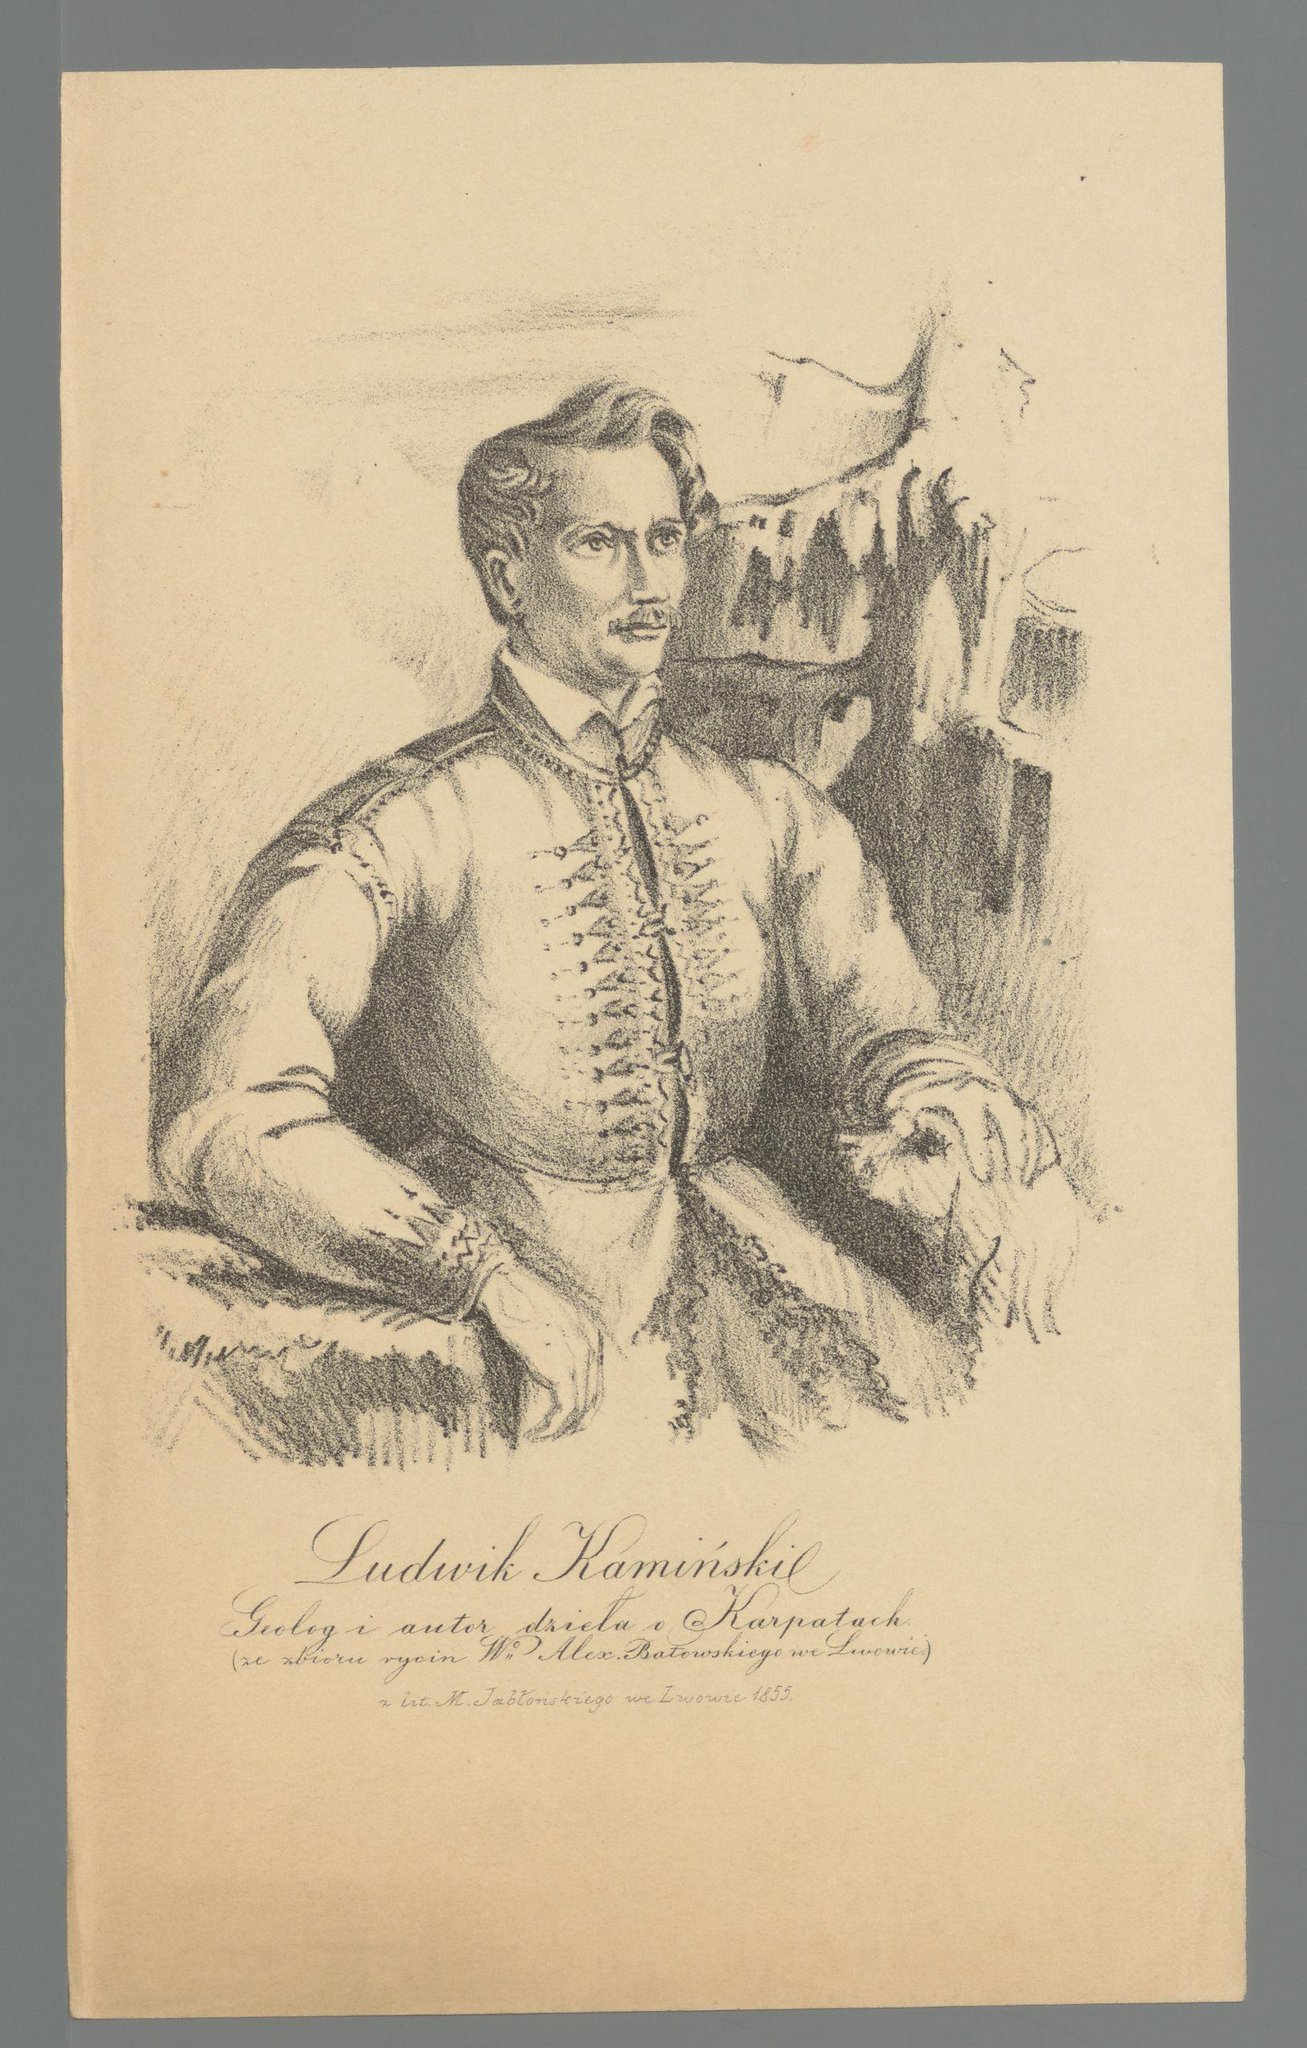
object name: print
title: Ludwik Kamiński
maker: martin jablonski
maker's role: print maker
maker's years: 1801-1876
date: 1855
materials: paper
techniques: lithograph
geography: lvov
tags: adult man, historical persons, dog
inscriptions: collector's mark: Lugt 2228